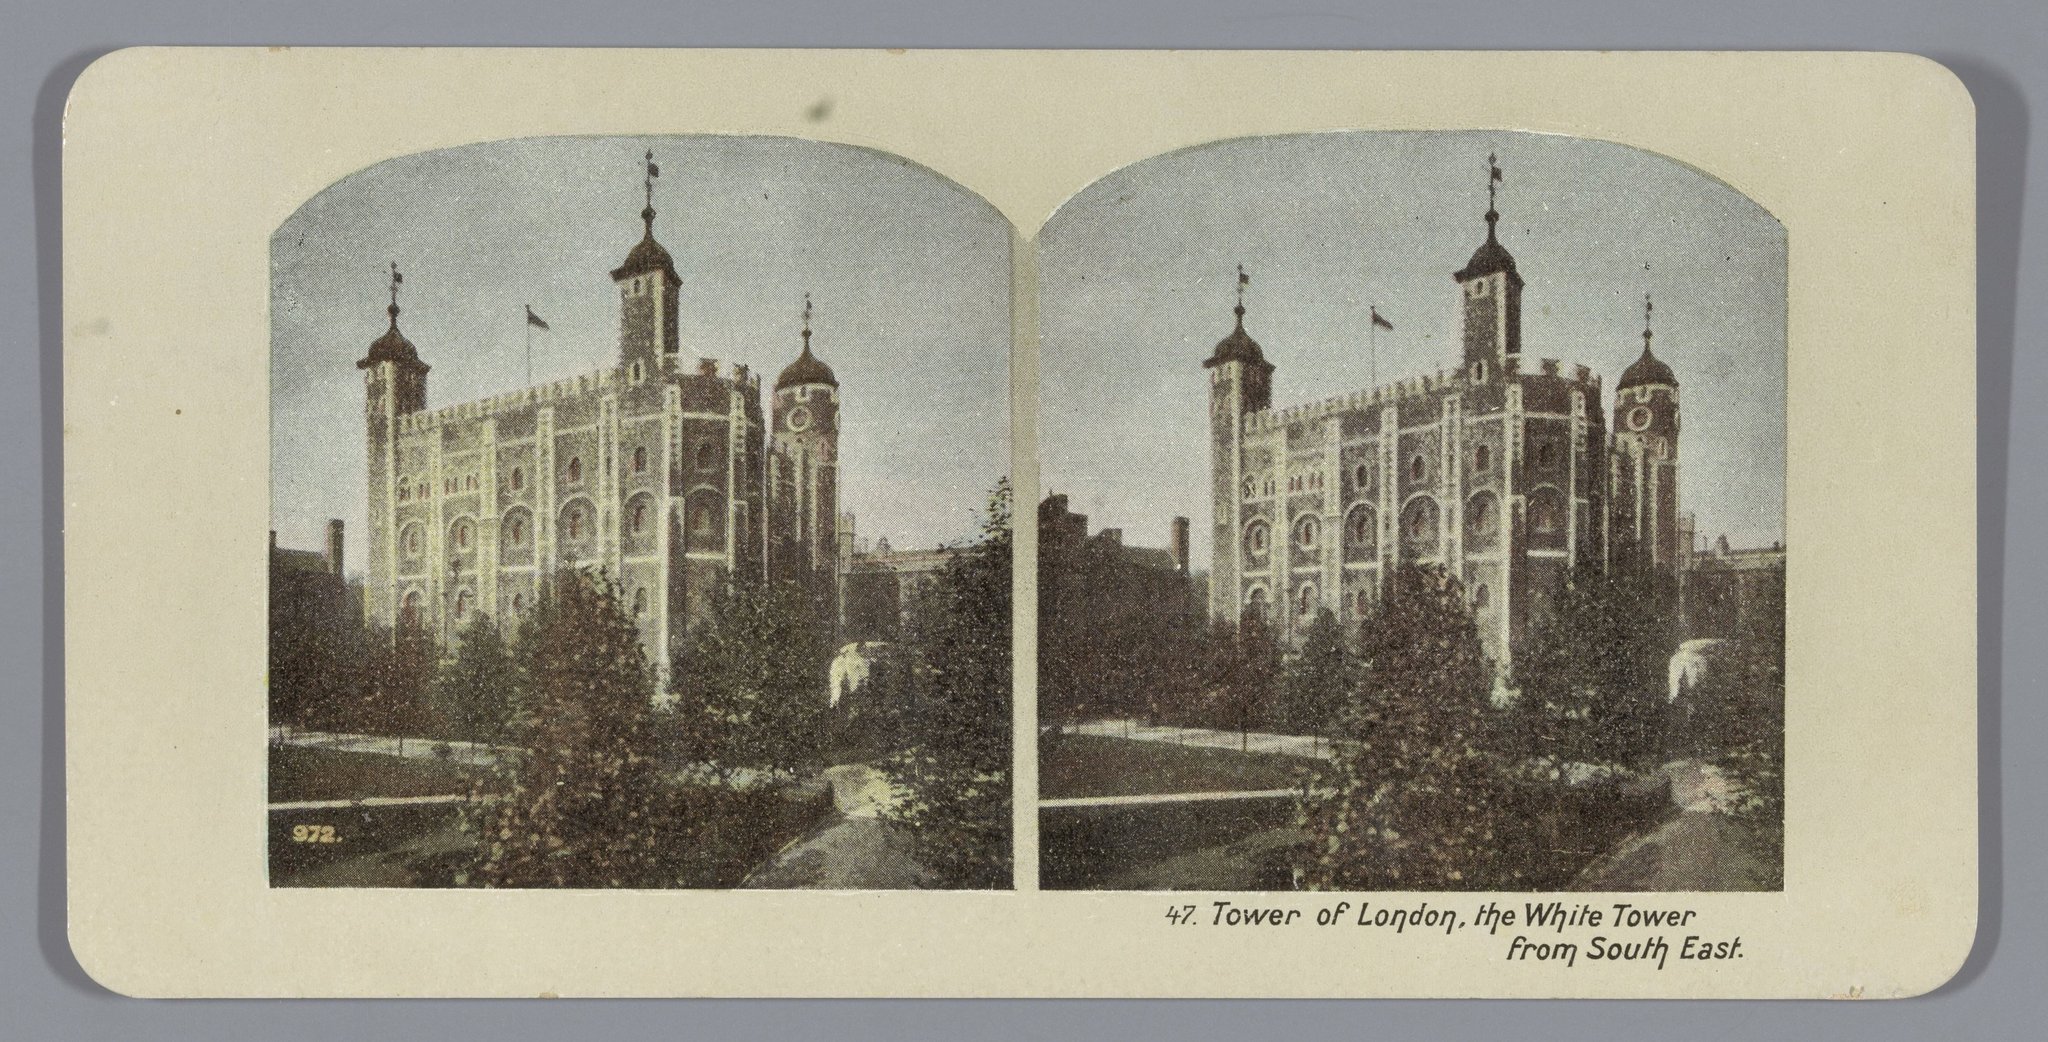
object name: stereograph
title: Gezicht op de Tower of London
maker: Anonymous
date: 1900-1940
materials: cardboard, paper, ink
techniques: color autotype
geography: london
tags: castle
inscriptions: number: ‘972.’, number: ‘47.’